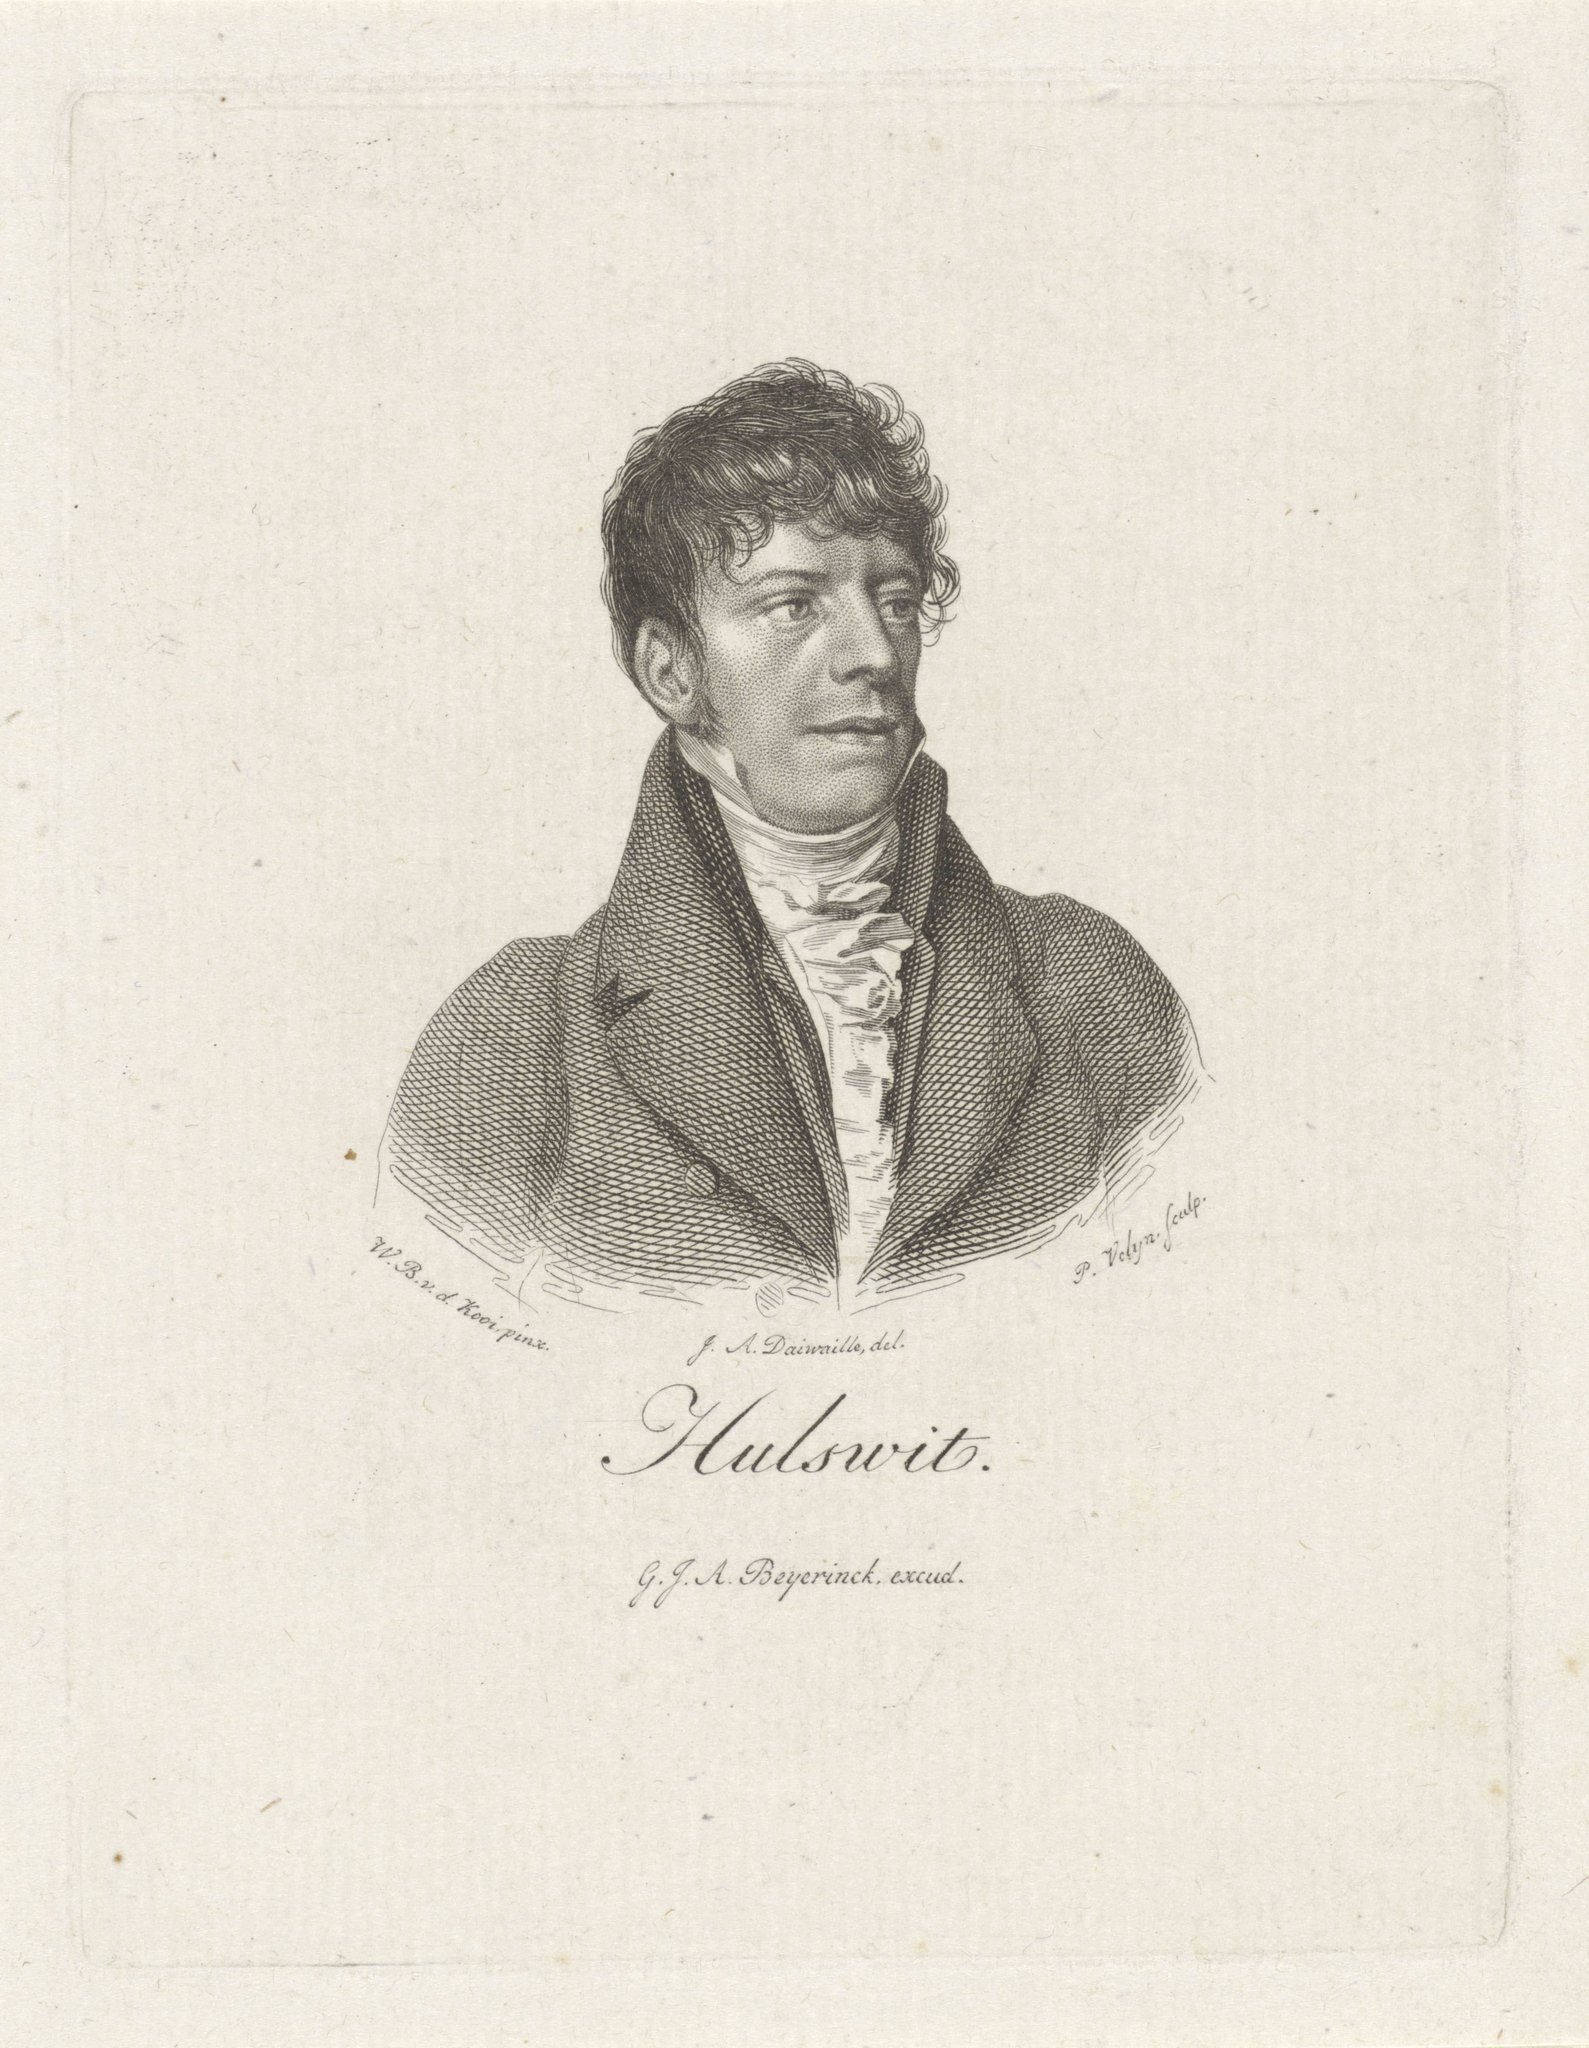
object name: print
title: Portret van Jan Hulswit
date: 1797-1836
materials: paper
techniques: engraving, etching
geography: netherlands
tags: draughtsman, jan hulswit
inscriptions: collector's mark: Lugt 2228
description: Portret van de Amsterdamse kunstschilder Jan Hulswit. Frontispies in de Almanak voor het Schoone en Goede, met het In Memoriam van Jan Hulswit.